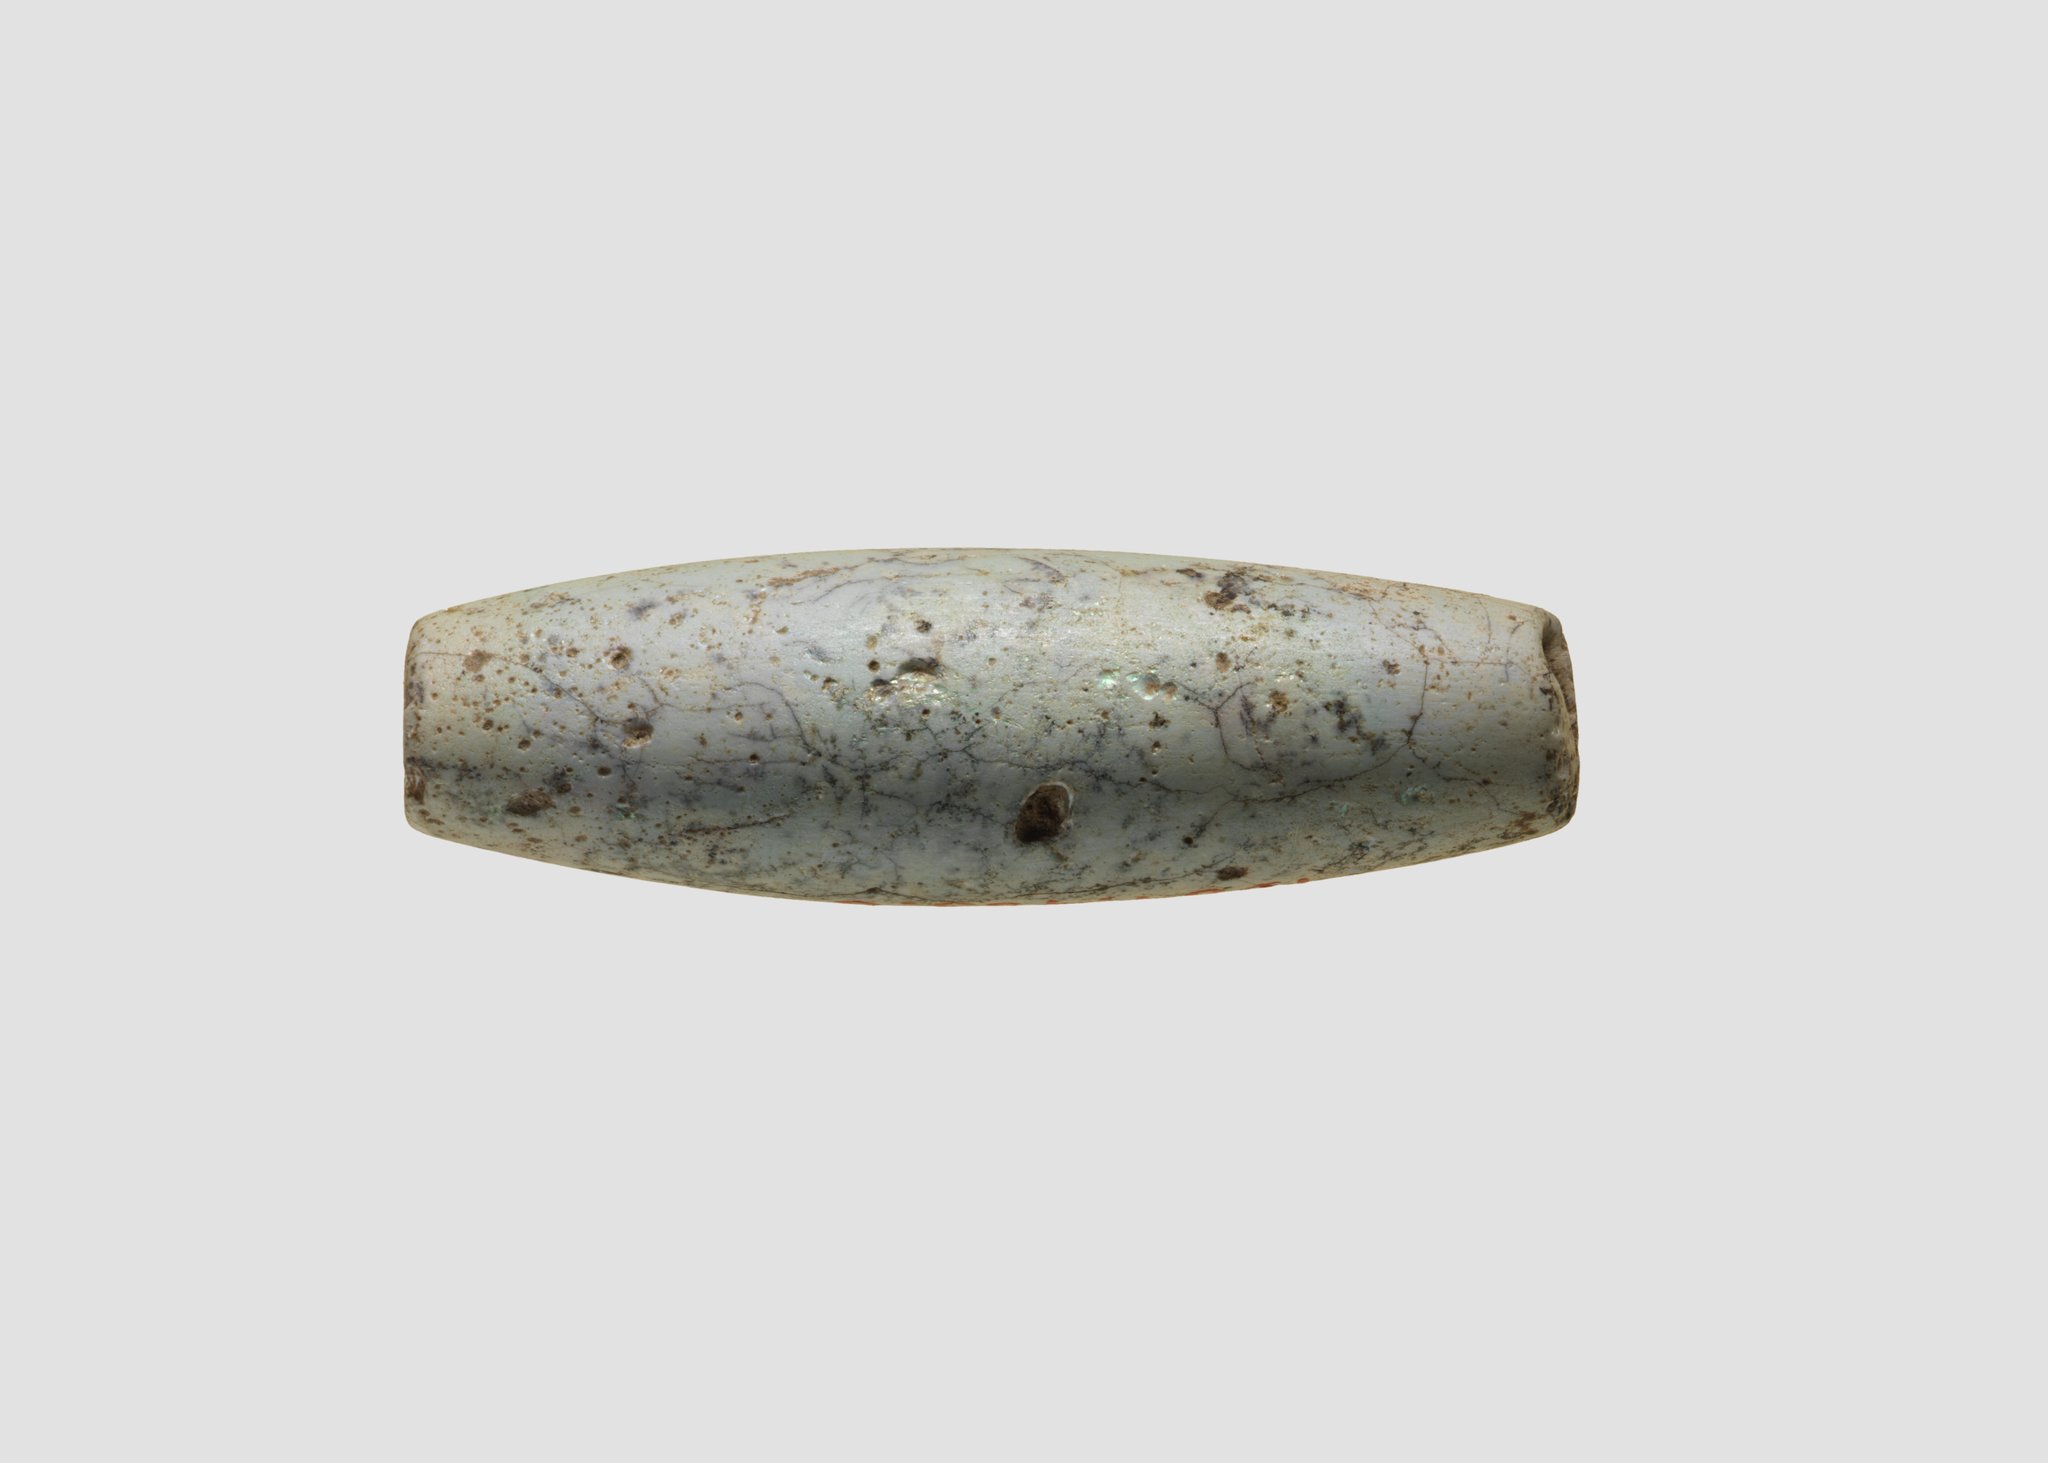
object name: bead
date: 1600-1301 BCE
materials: glass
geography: mesopotamia or syria